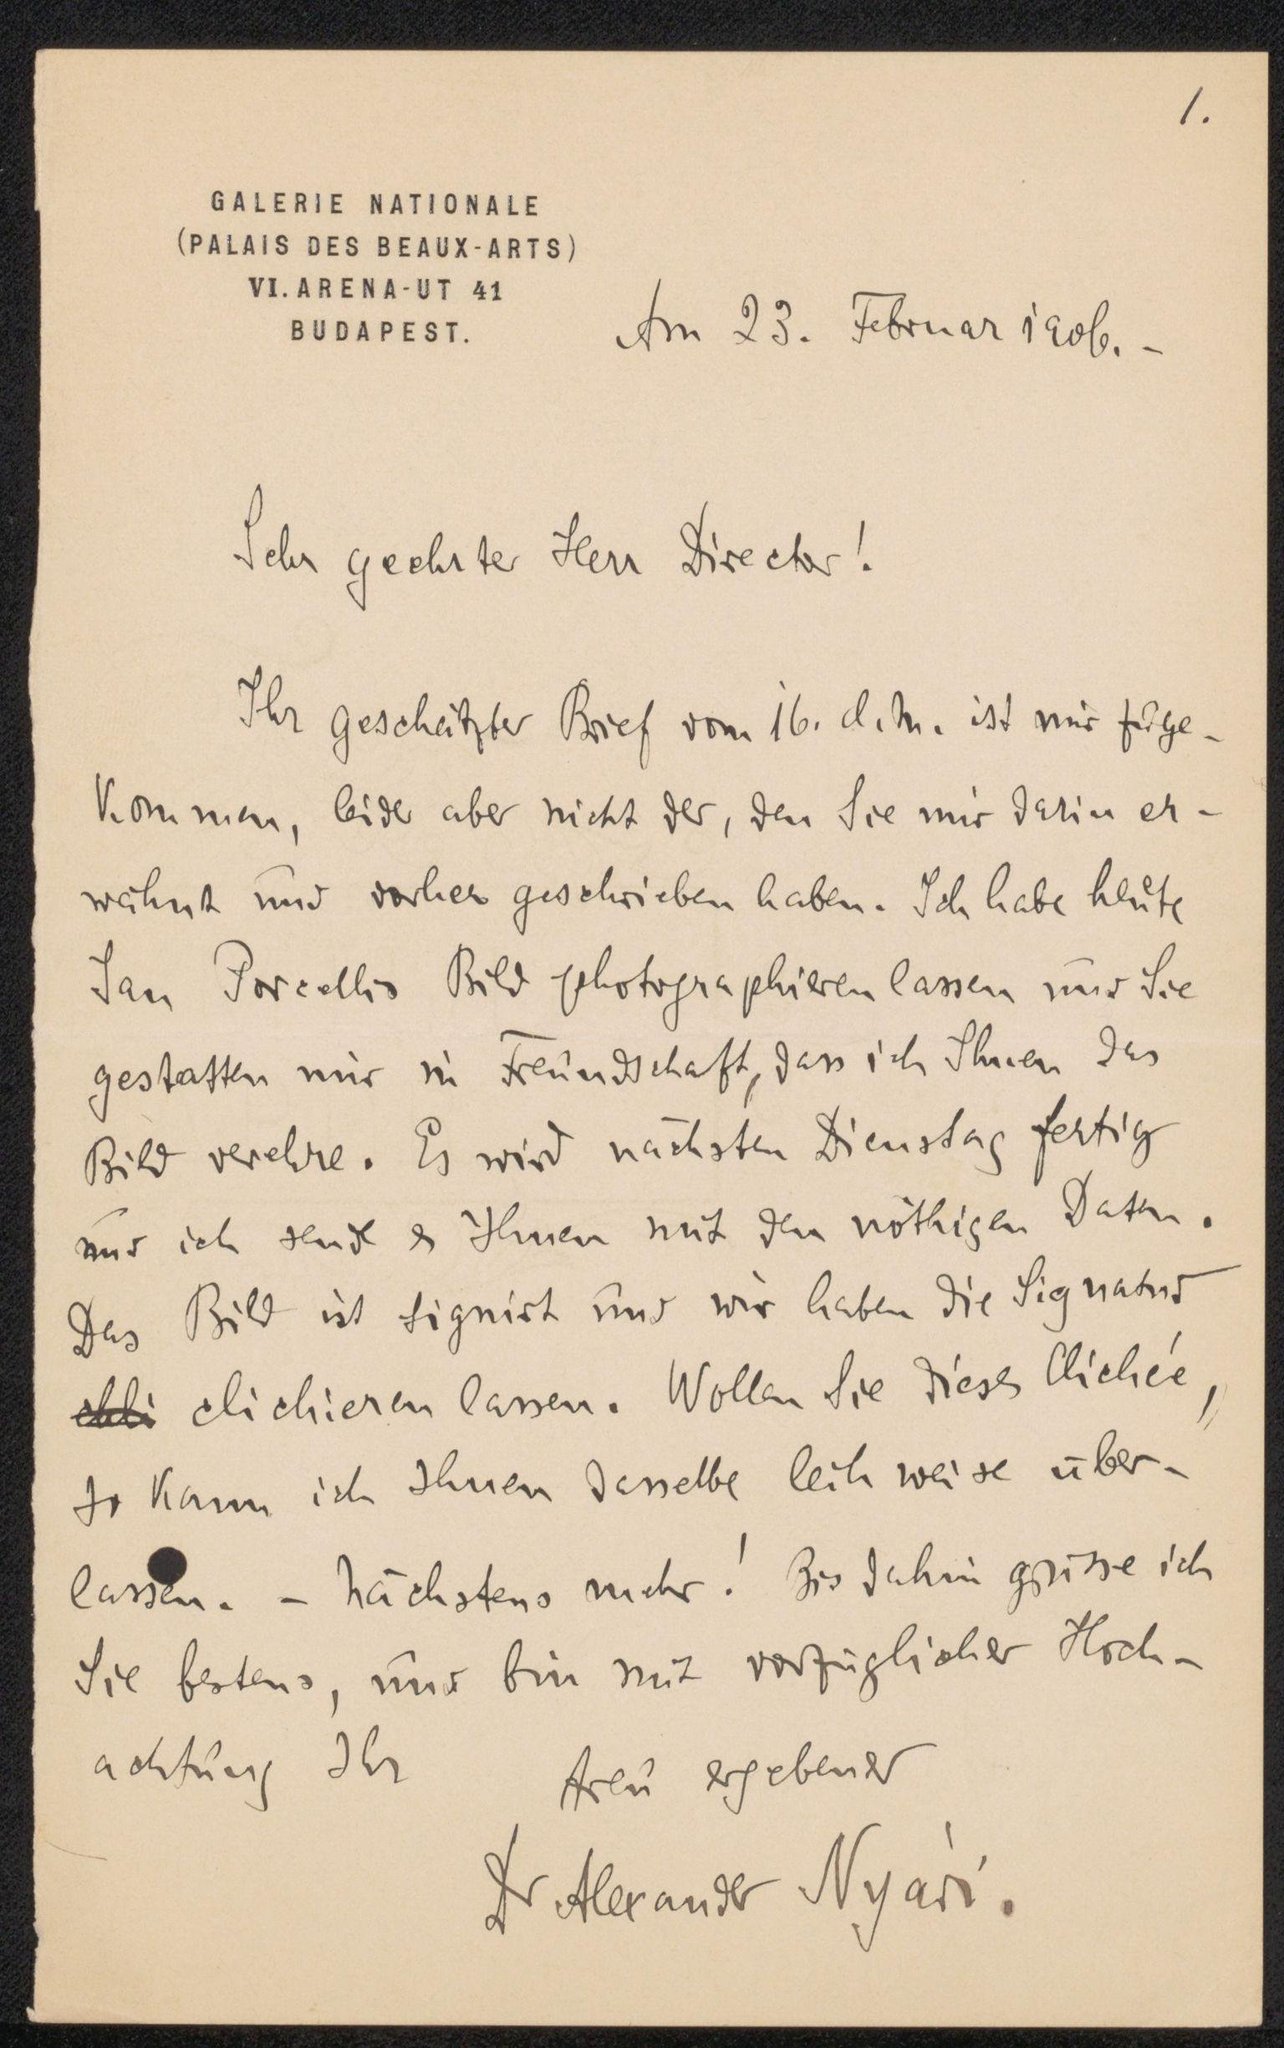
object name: letter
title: Brief aan Pieter Haverkorn van Rijsewijk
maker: alexander nyári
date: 1906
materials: ink, paper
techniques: pen, printing, writing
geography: budapest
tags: pieter haverkorn van rijsewijk, ghent, painter, draughtsman, jan porcellis, photography, cinematography, painting (including book-illumination, miniature-painting)